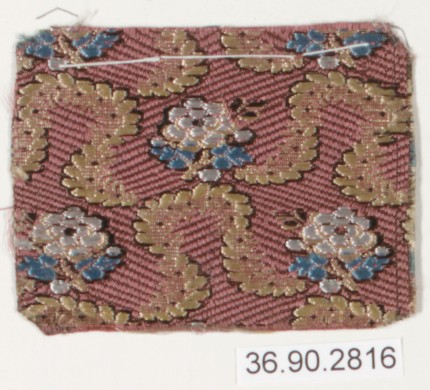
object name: piece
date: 1801-1900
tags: flowers,leaves